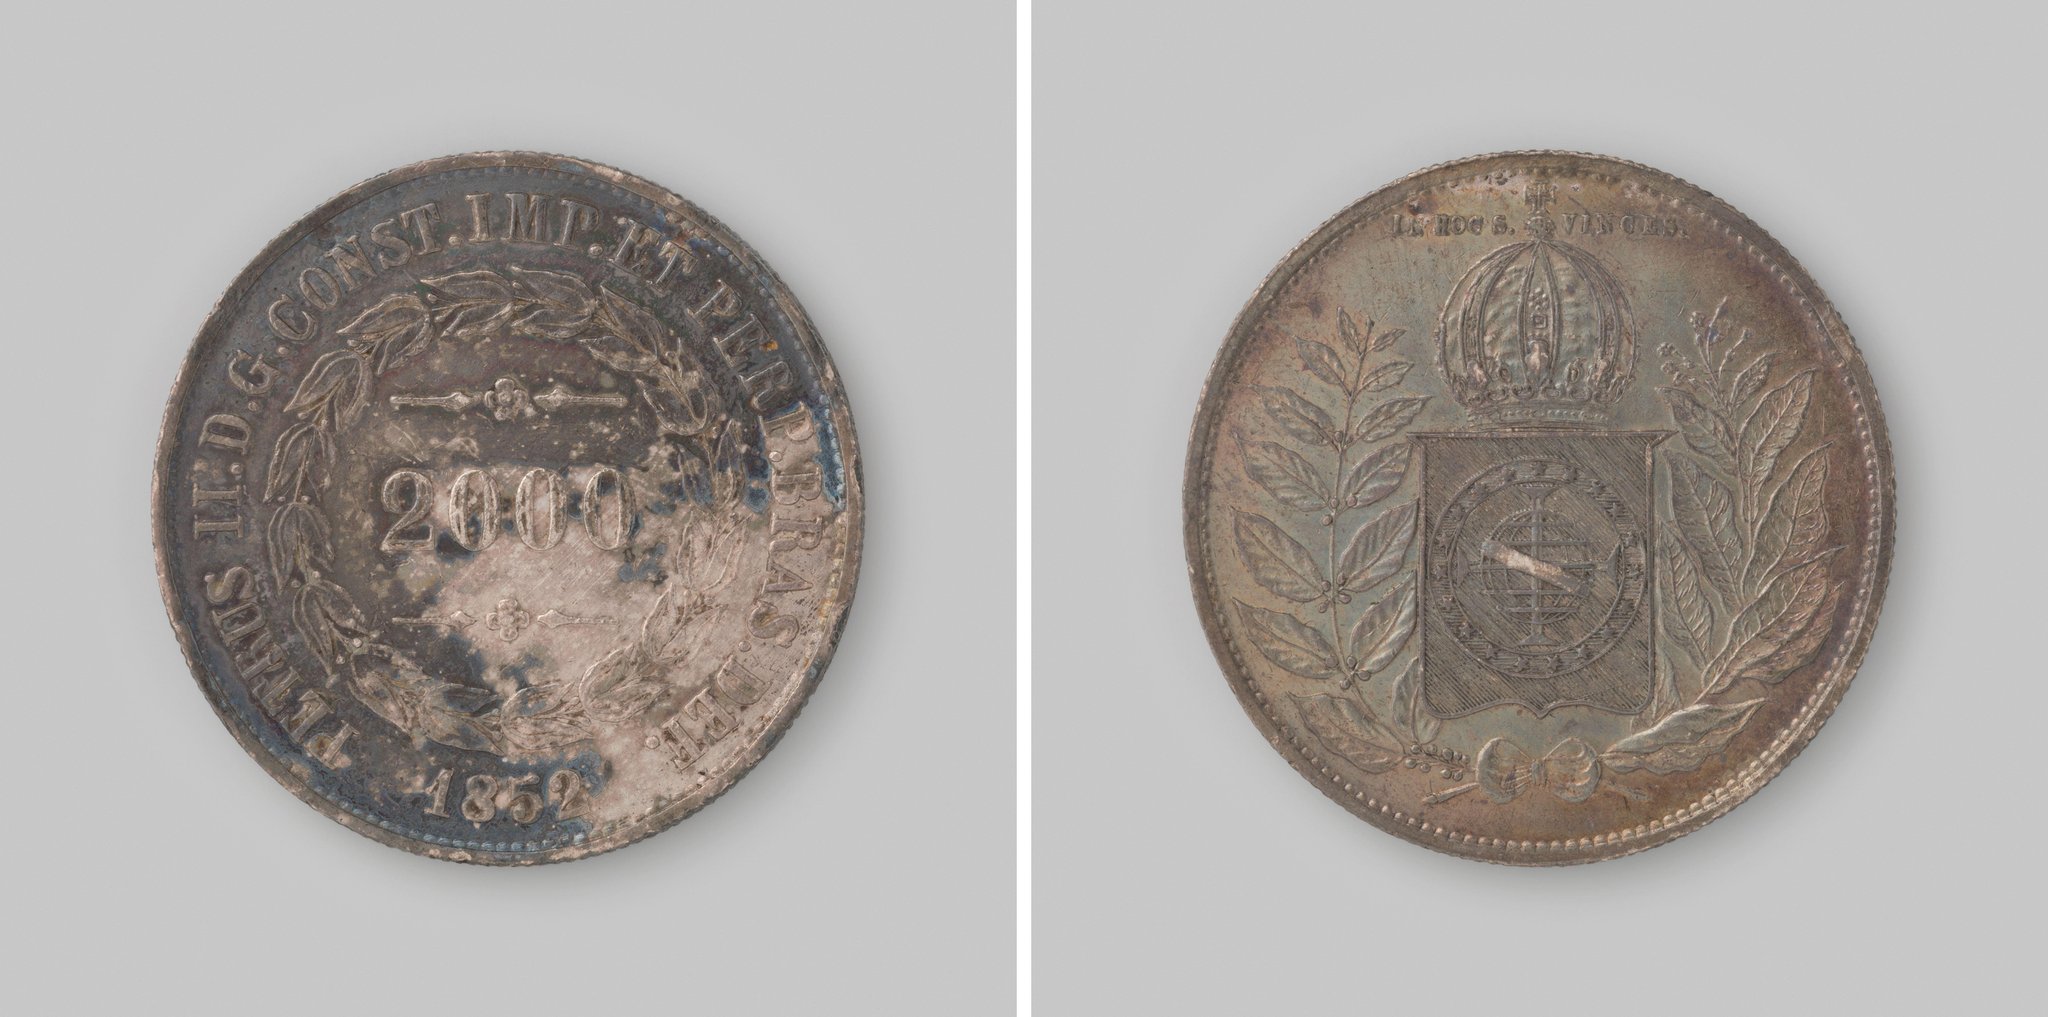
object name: coin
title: Patacano van 2000 reis van het keizerrijk Brazilië van D. Pedro II, 1852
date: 1852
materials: silver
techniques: striking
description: Zilveren munt. Voorzijde: binnen cirkel van bloemen waarde-aanduiding: 2000. In omschrift onderaan jaartal. Keerzijde: tussen twee samengebonden takken gekroond wapenschild van Brazilië. Kartelrand.